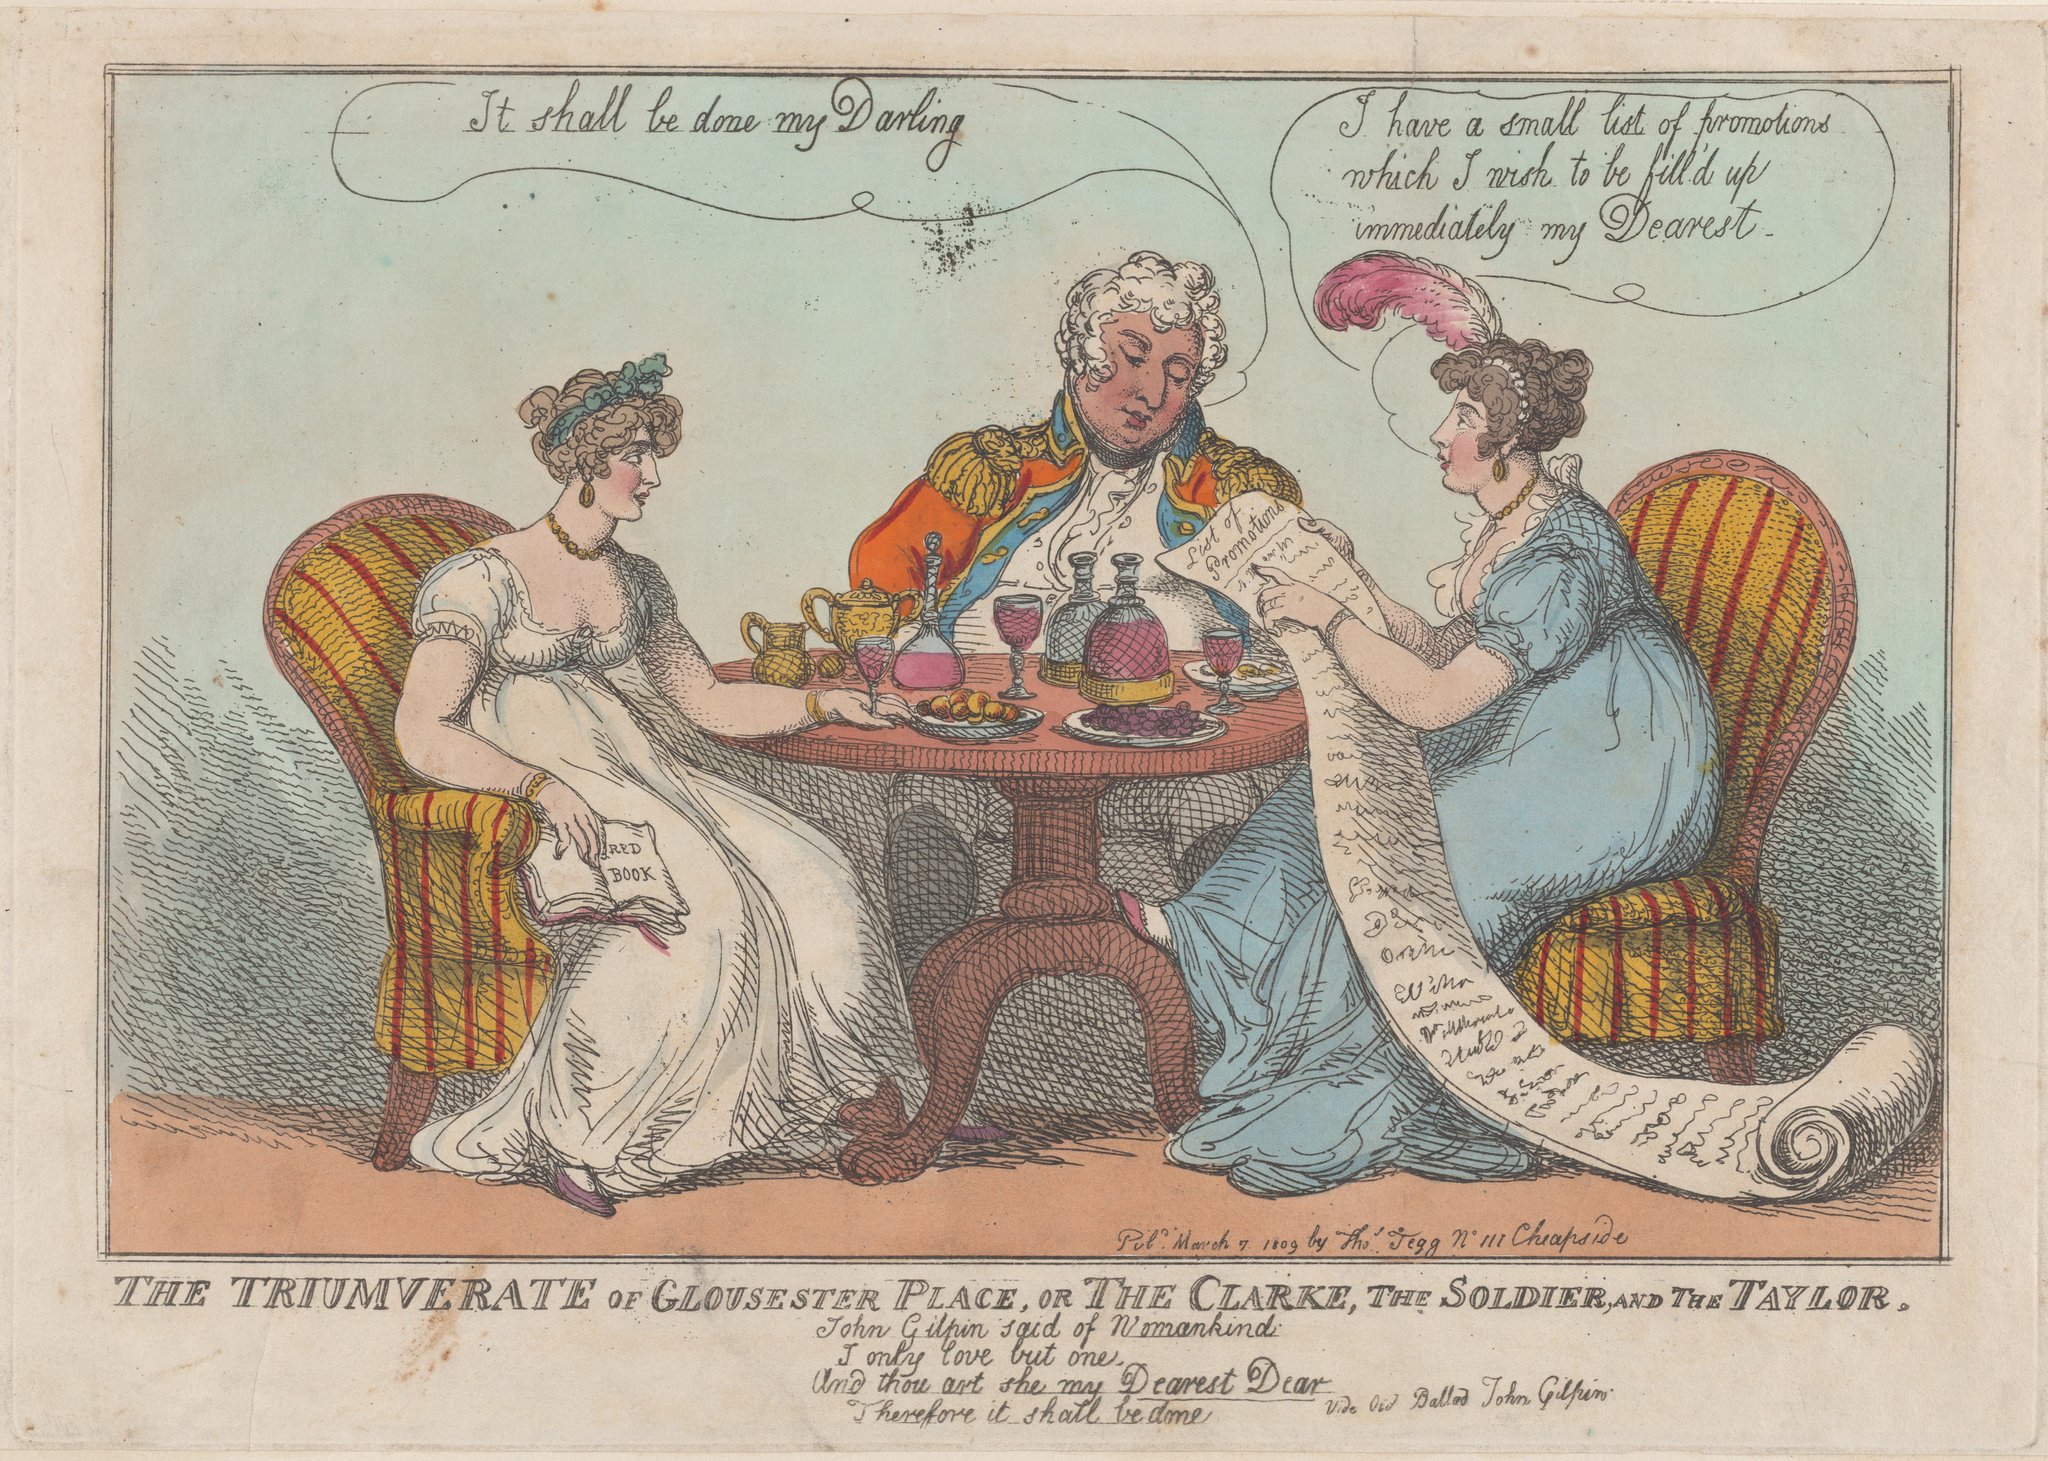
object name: print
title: The Triumverate of Gloucester Place, or The Clarke, The Soldier, and The Taylor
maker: thomas rowlandson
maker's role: artist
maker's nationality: british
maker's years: 1757-1827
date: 1809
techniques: etching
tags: satire,men,women,politics